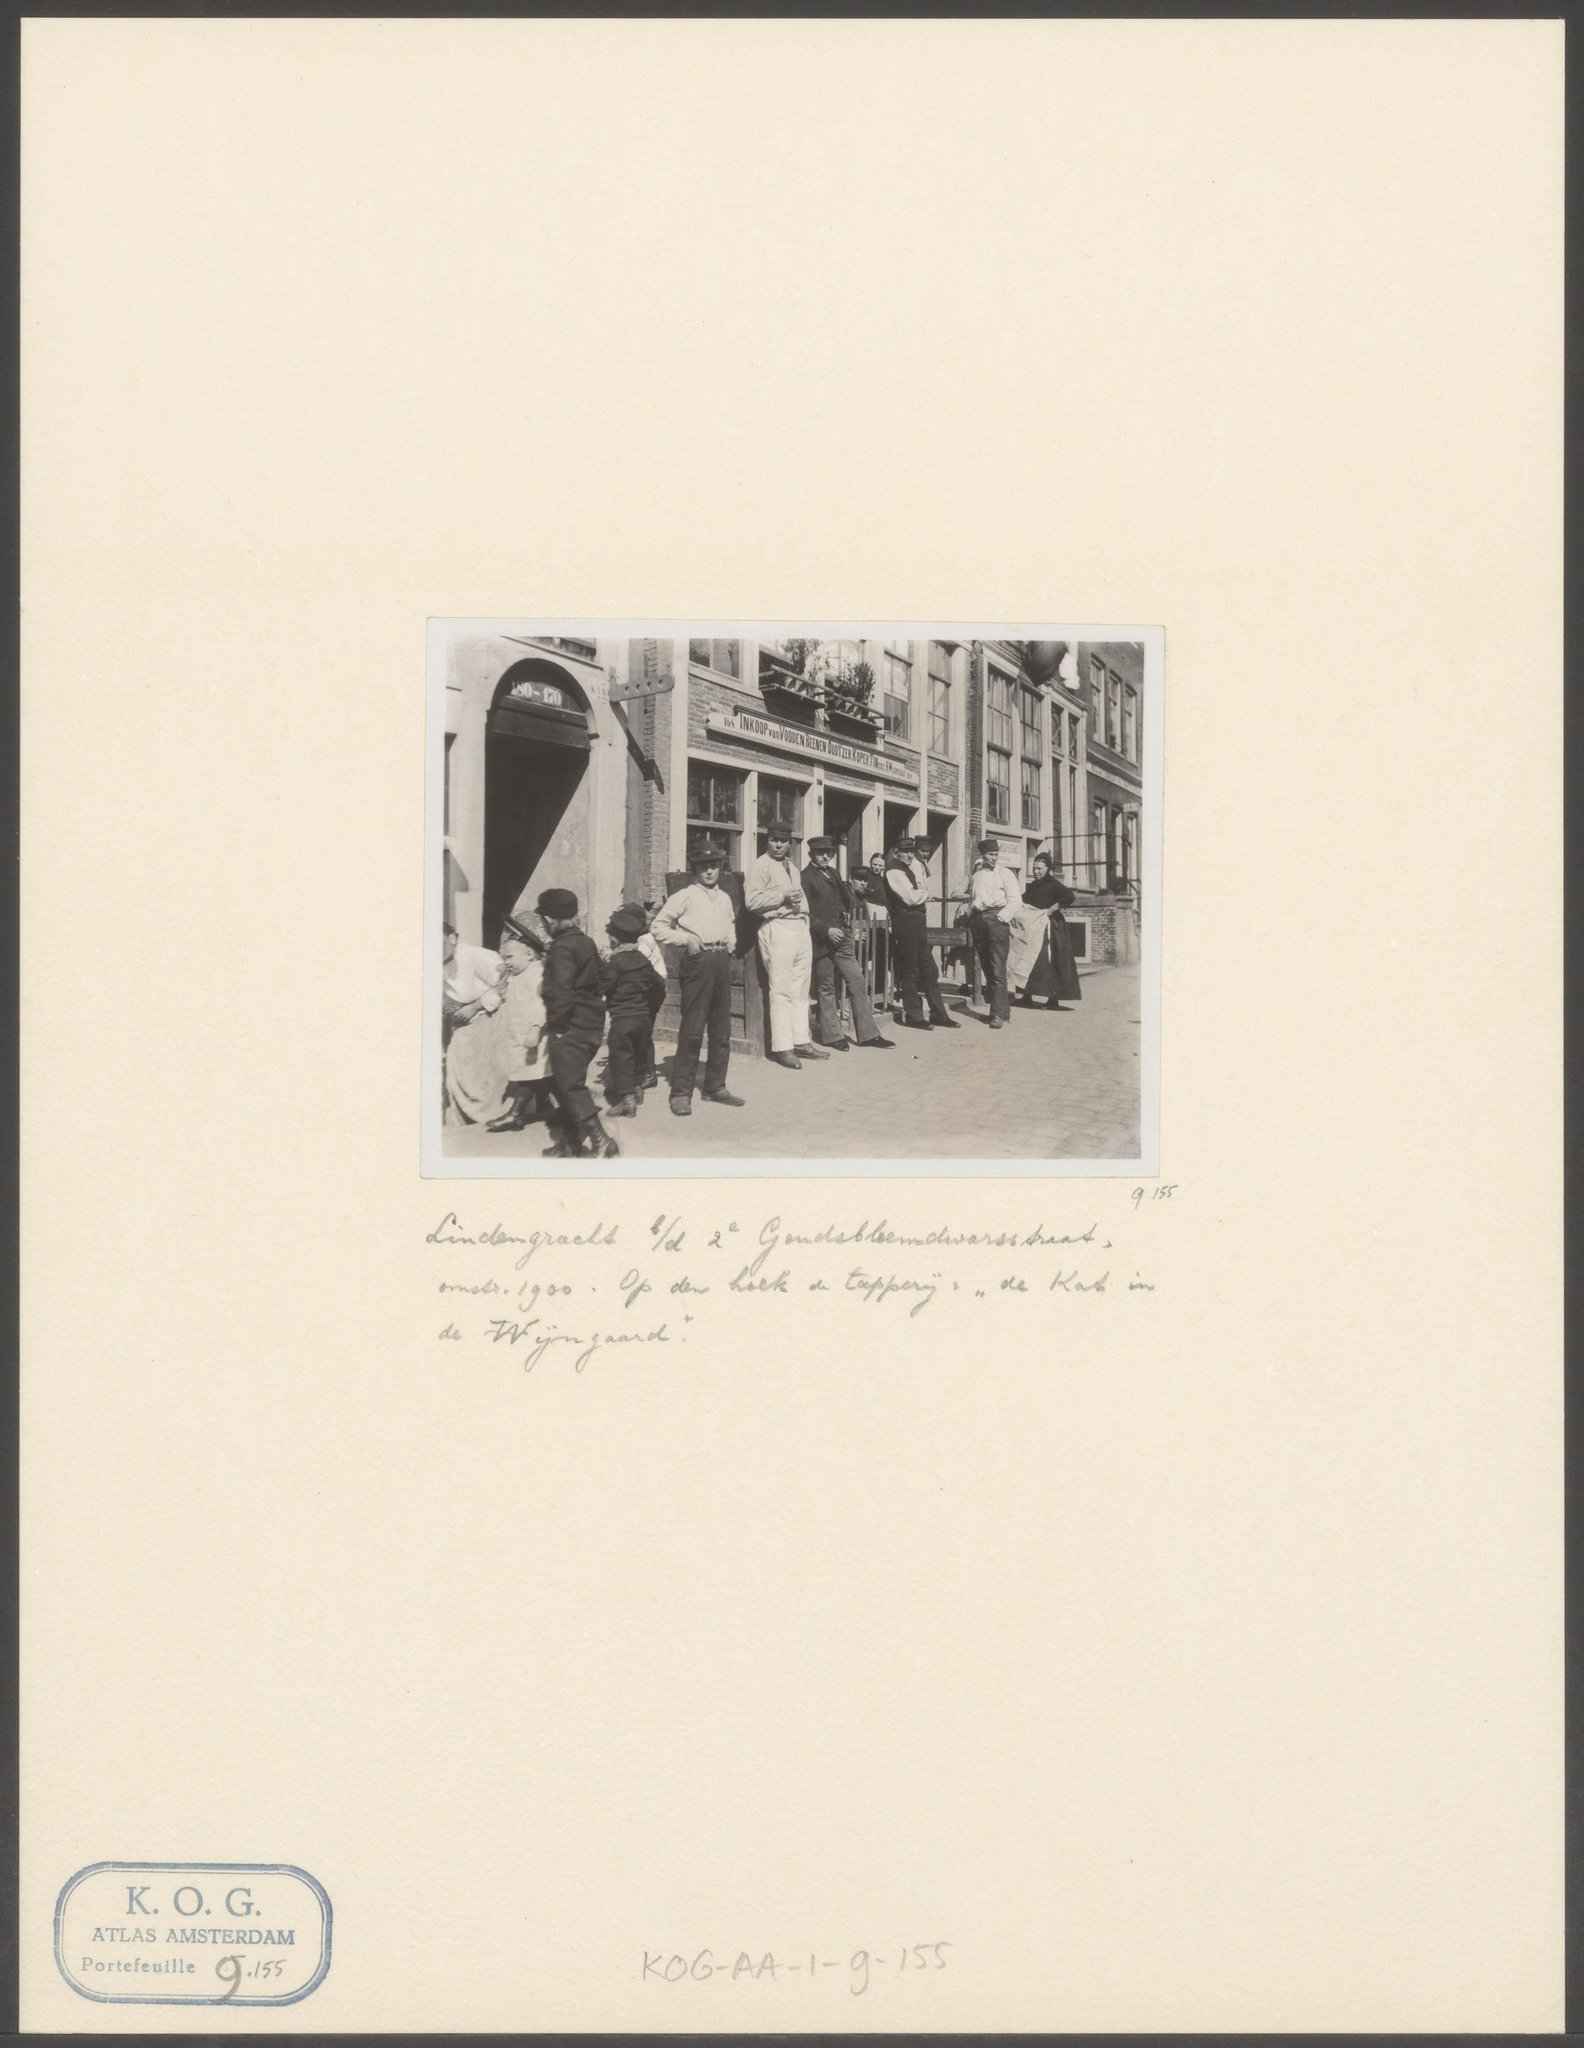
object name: photograph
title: Gezicht op de Lindengracht, hoek Tweede Goudsbloemdwarsstraat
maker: Anonymous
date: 1900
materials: paper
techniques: gelatin silver print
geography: amsterdam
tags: city-view in general; 'veduta', inn, coffee-house, public house, etc., the usual house or row of houses, street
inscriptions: inscription: ‘Lindengracht b/d 2e (...) in / de Wijngaard."’, collector's mark: ‘9.155’ Lugt 1641b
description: Onderwerpsrubriek binnen de Atlas Amsterdam: 2e Laurierdwarsstraat (Vuile Weespad), Leidschegracht, Leidschekade, Leidscheplein, Leidschestraat, v. Lennepkade, Lijnbaansgracht, Lauriergracht, Leliedwarsstraat, Leliegracht, Lindengracht, Lombardsteeg, Looiersgracht, Looiersstraat (Nieuwe), Leidekkerssteeg.